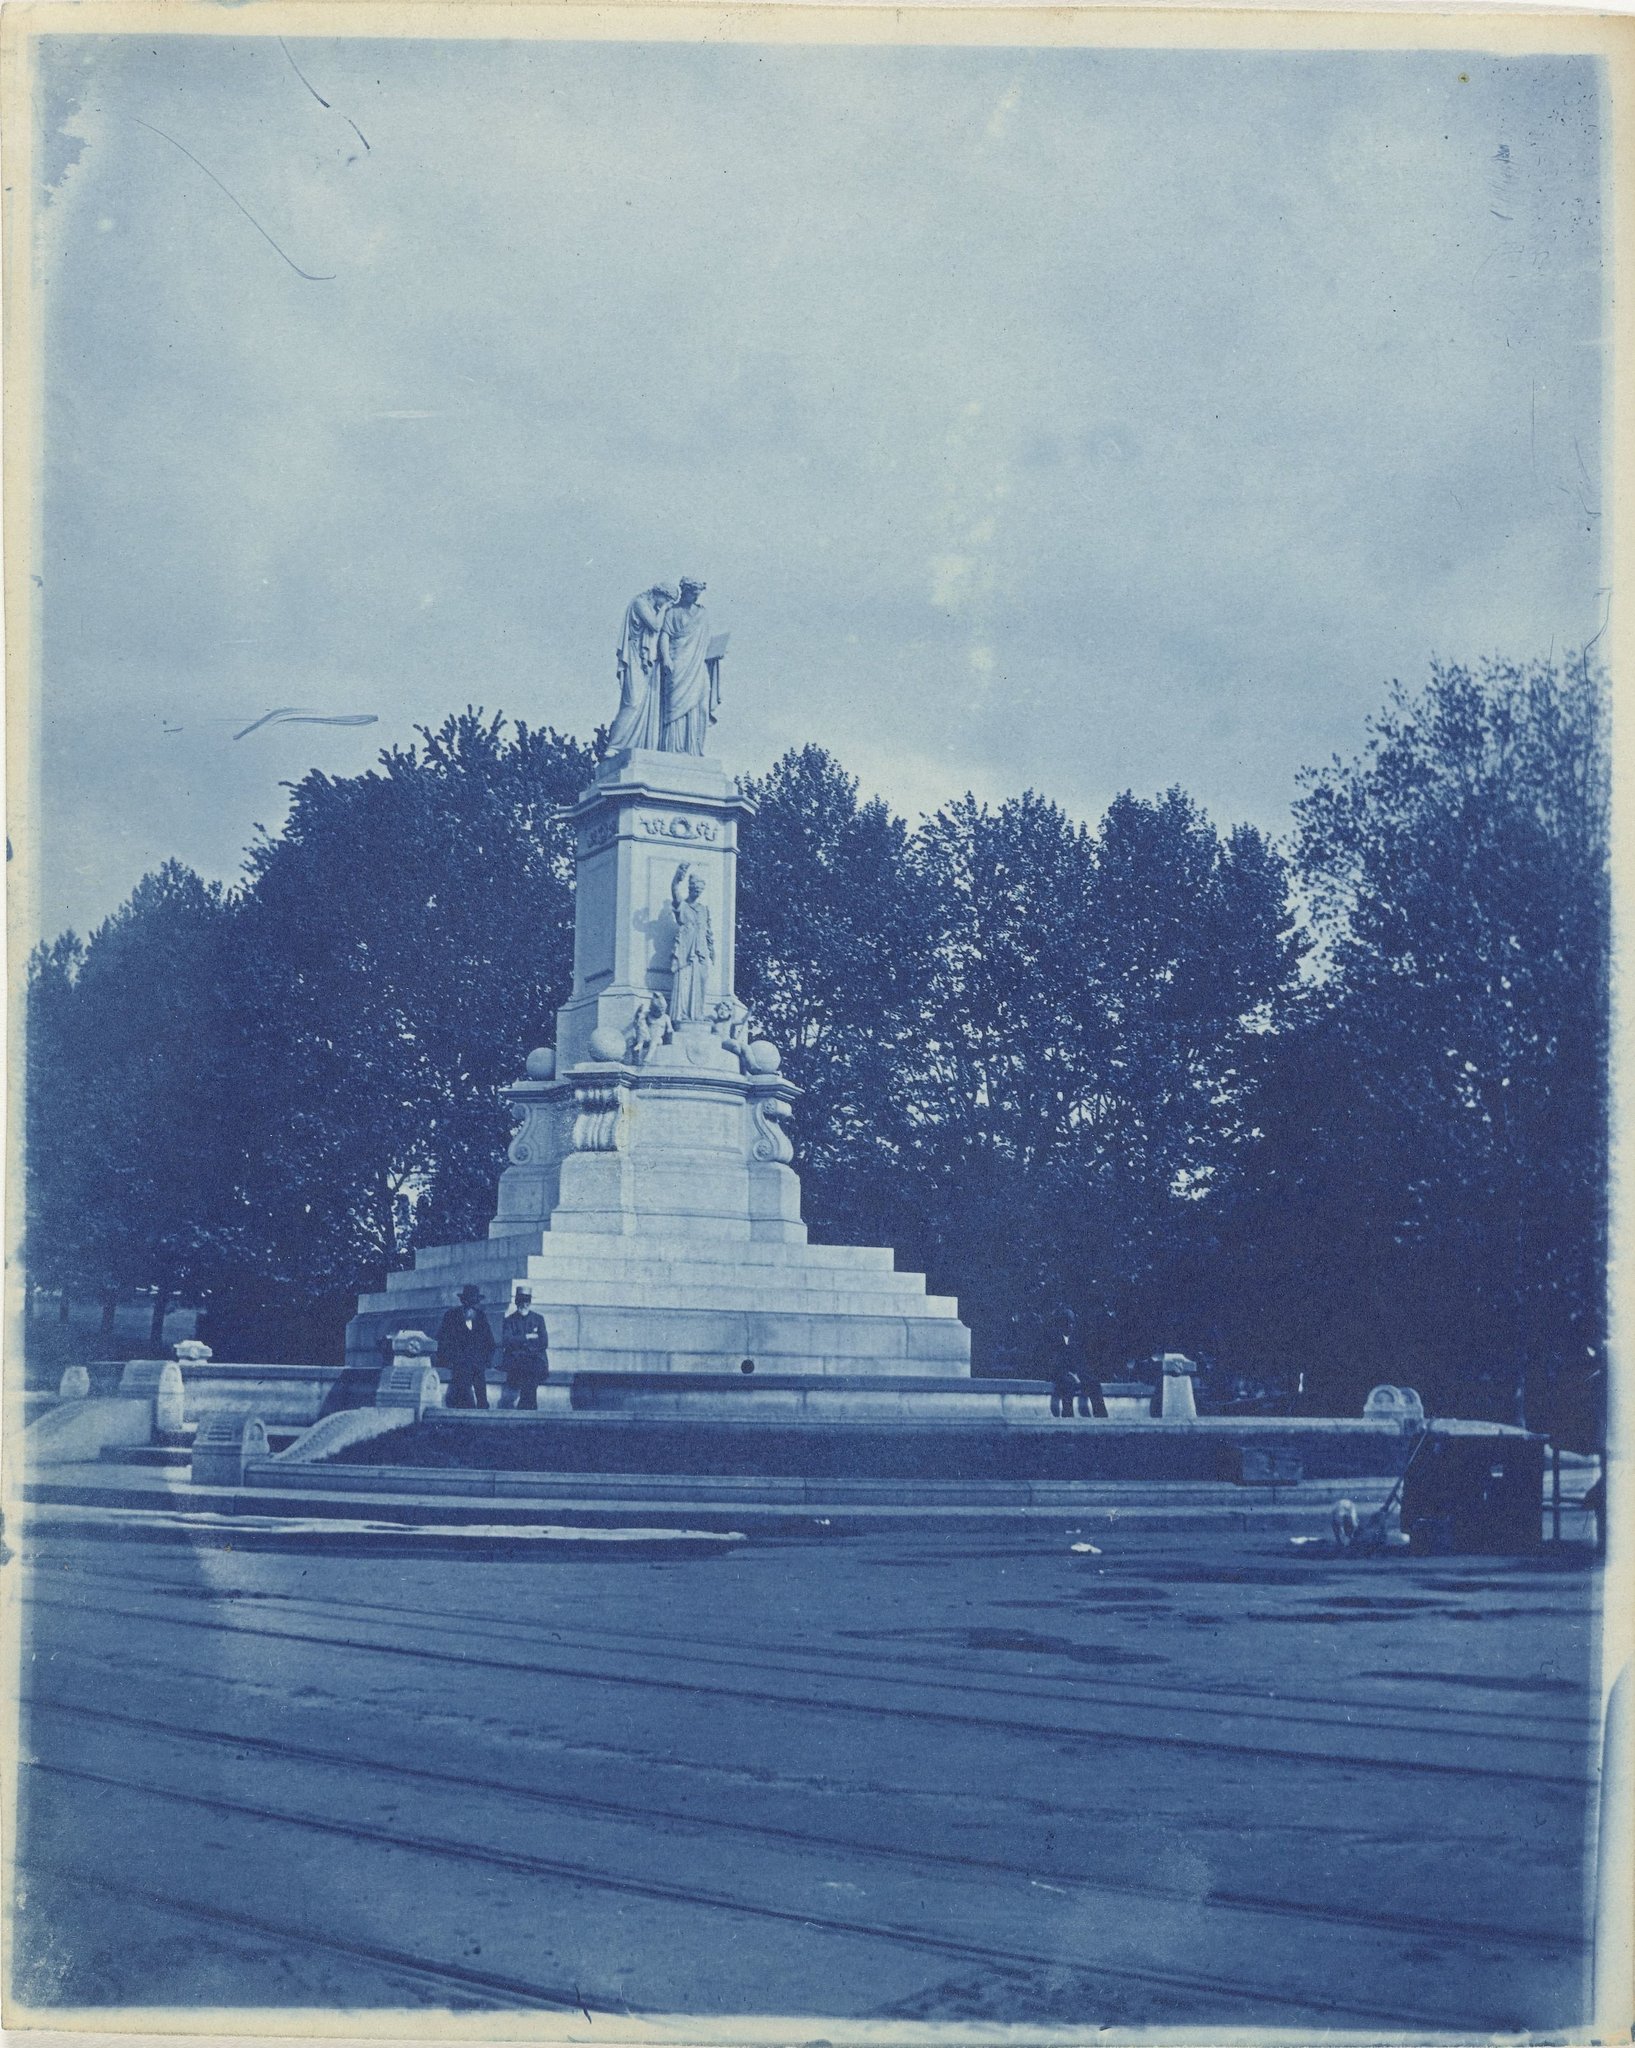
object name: photograph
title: Gezicht op een monument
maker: Anonymous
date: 1890-1920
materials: paper, photographic support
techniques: cyanotype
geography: france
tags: monument, statue